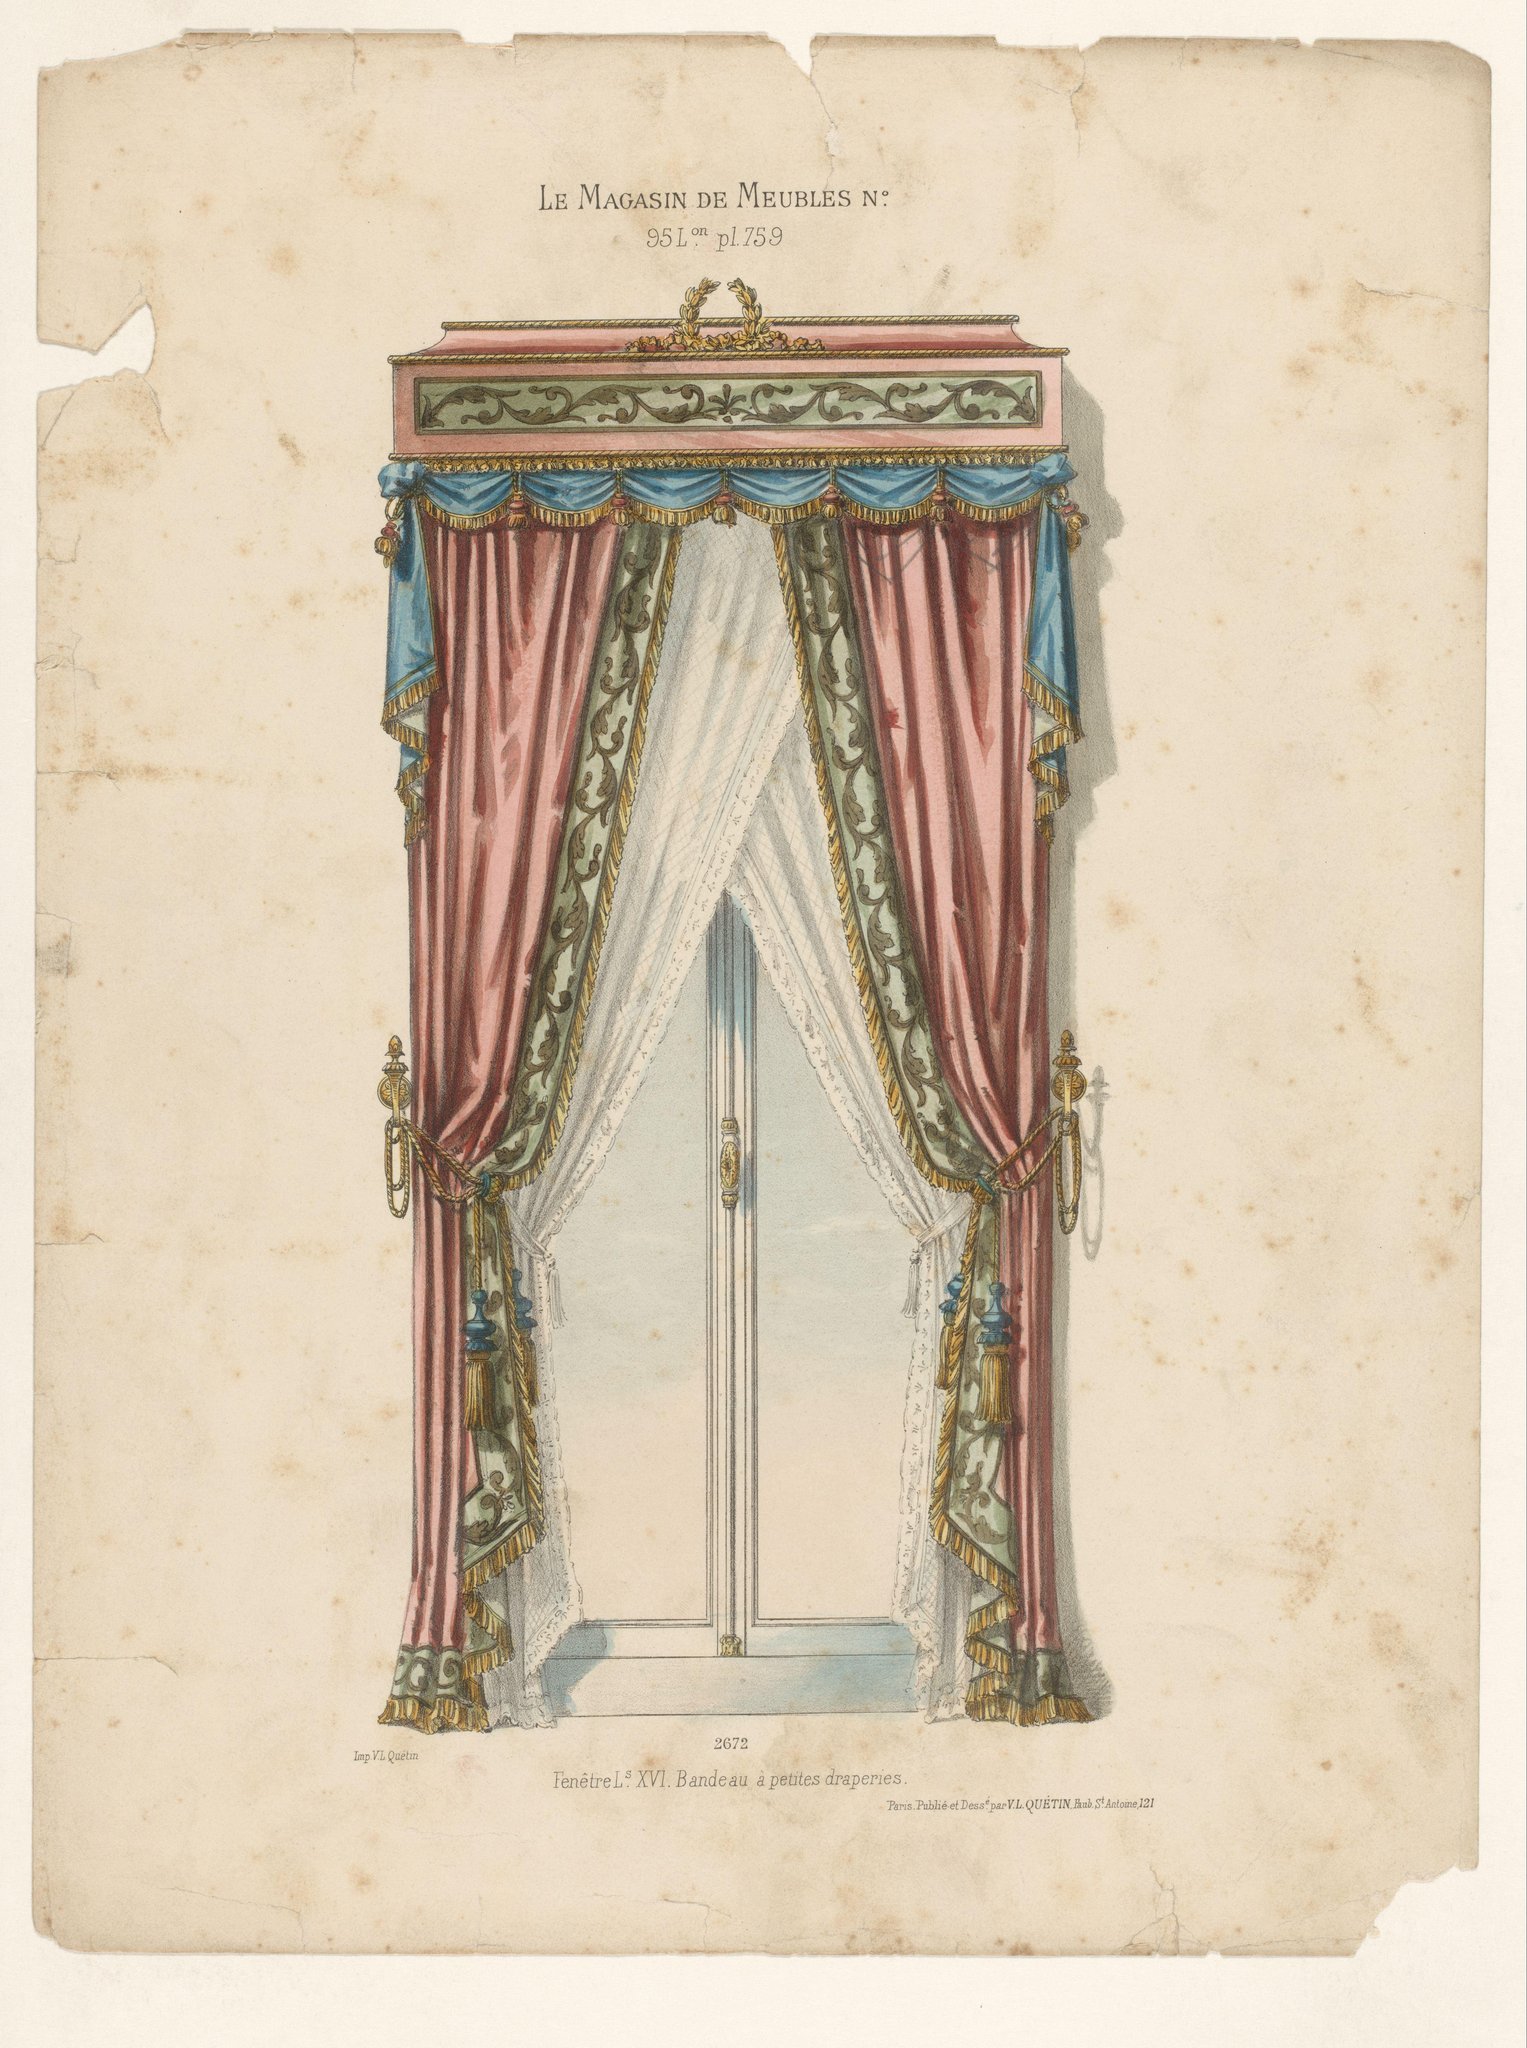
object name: print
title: Le Magasin de Meubles No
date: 1878-1904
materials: paper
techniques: hand coloring, lithograph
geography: paris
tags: window, hangings and drapery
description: Een venster met gedrapeerde gordijnen in de Lodewijk XVI-stijl. Prent uit 95e Livraison.